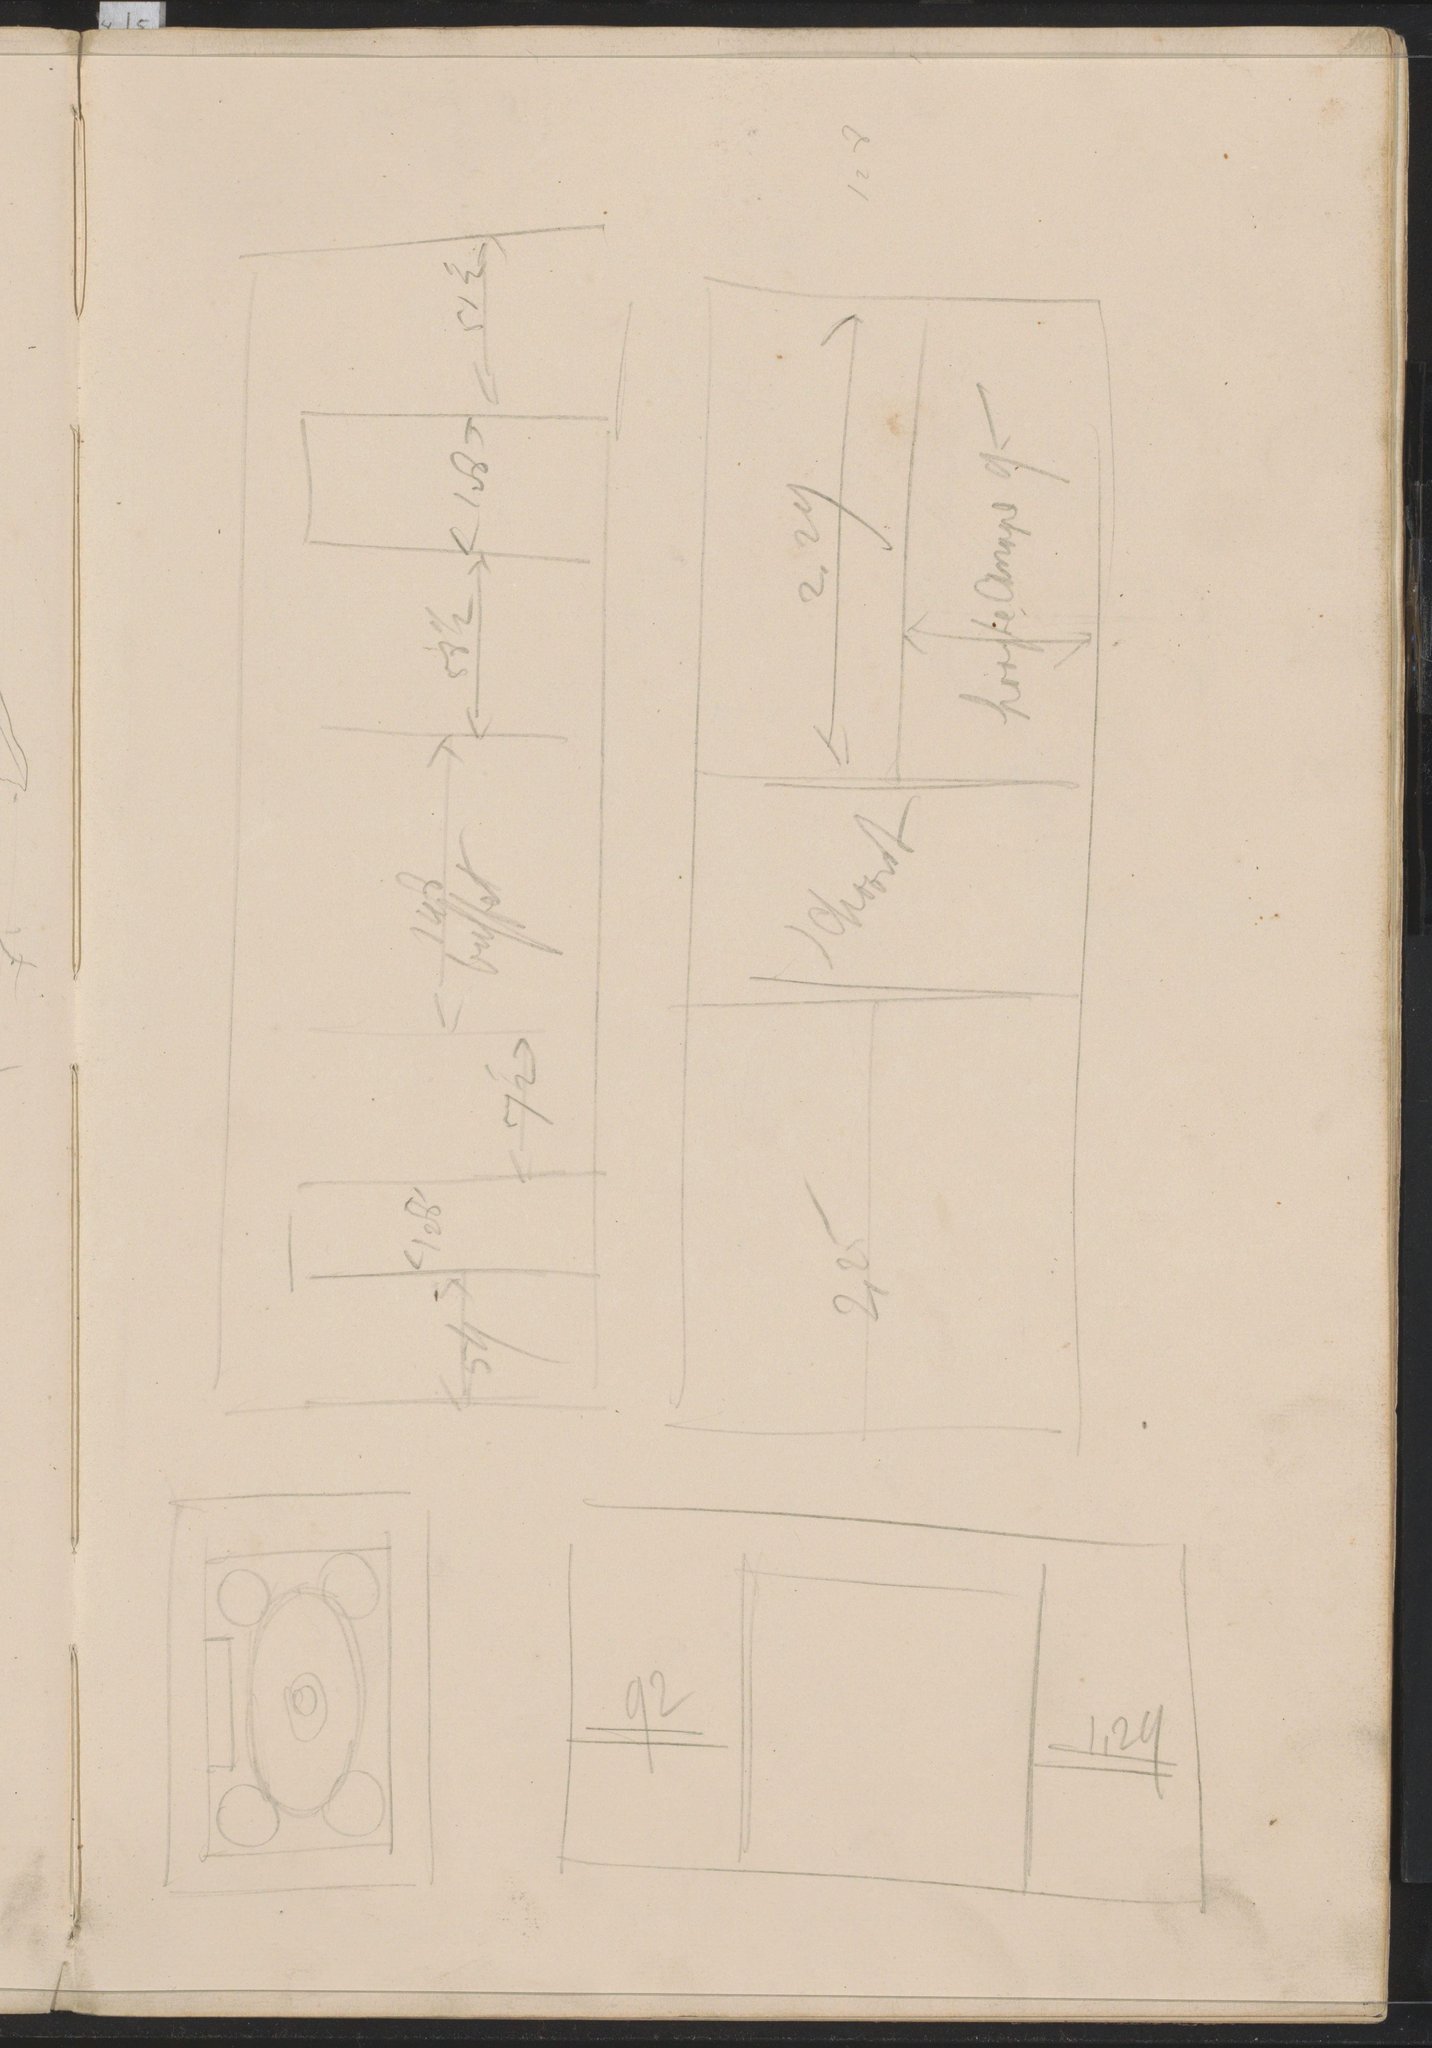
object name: sketchbook leaf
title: Plattegronden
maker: carel adolph lion cachet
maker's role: draughtsman, print maker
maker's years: 1864-1945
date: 1903-1904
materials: paper, pencil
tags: plan ~ architecture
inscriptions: annotation: ‘[...] buffet/ [...]/ schoorst/ [...]’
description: Vermoedelijk een ontwerp voor de indeling van een interieur. Blad 4 recto uit een schetsboek met 17 bladen.